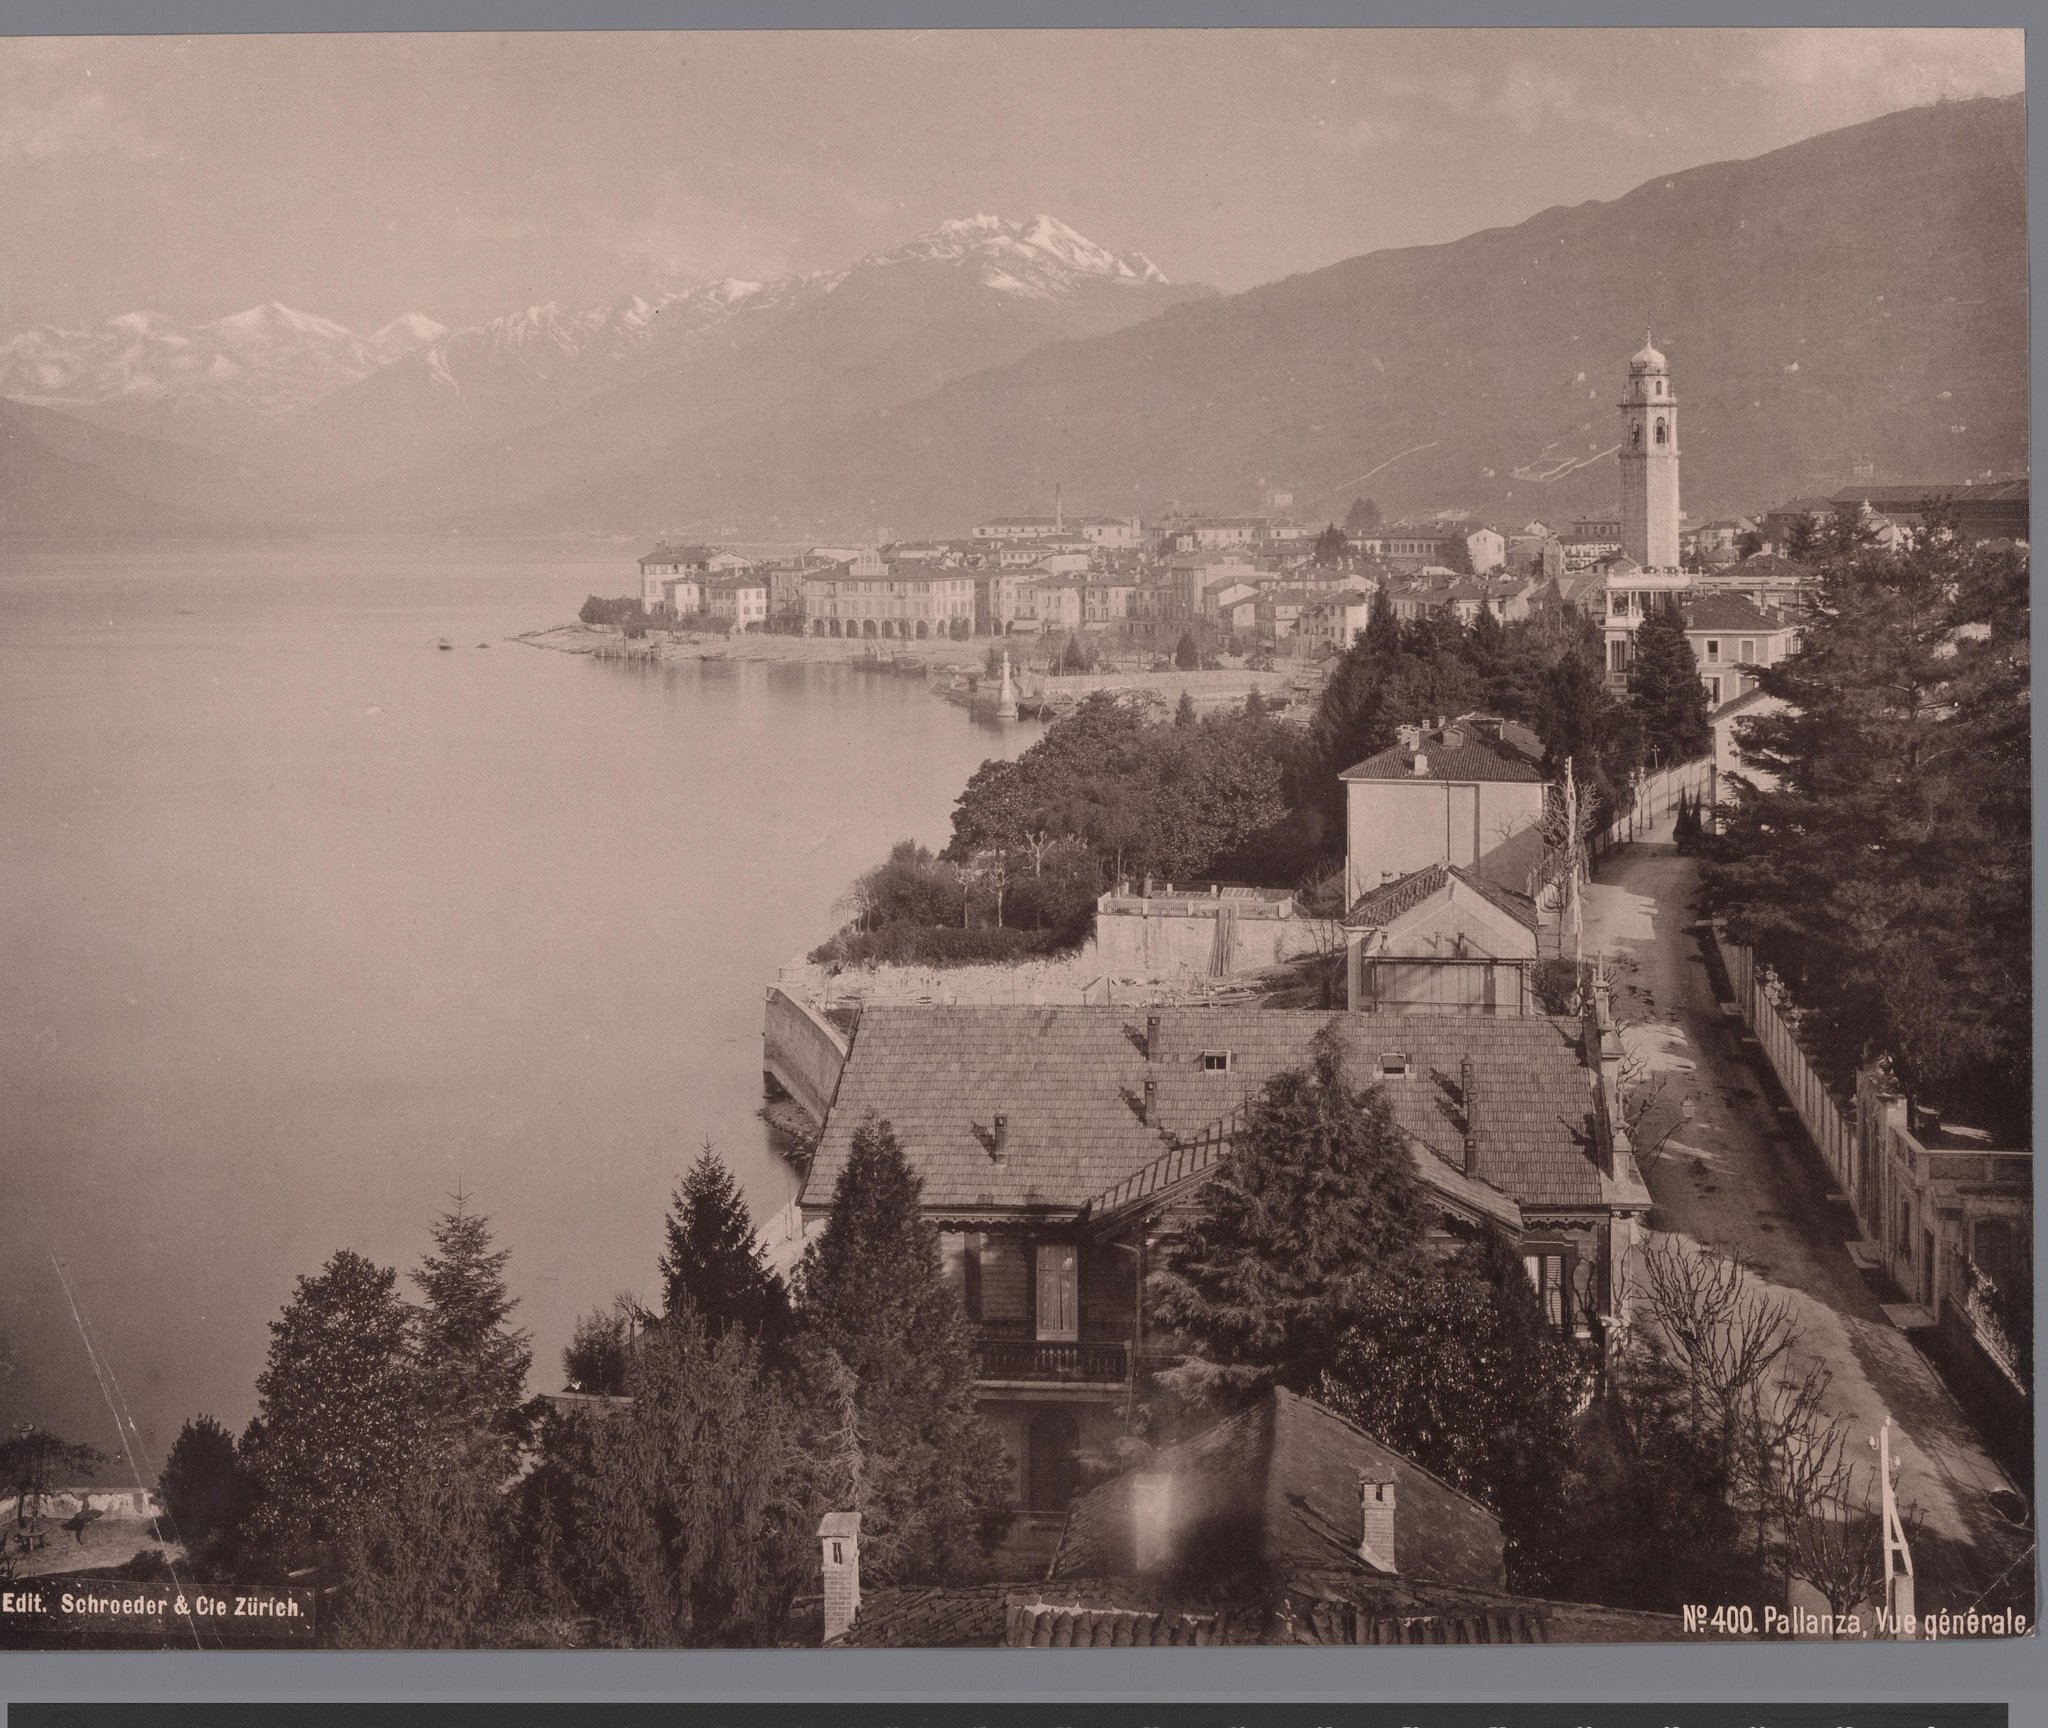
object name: photomechanical print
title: Pallanza, vue générale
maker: Anonymous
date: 1870-1895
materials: paper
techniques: photograph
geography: pallanza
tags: city-view in general; 'veduta'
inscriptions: number: ‘No 400.’